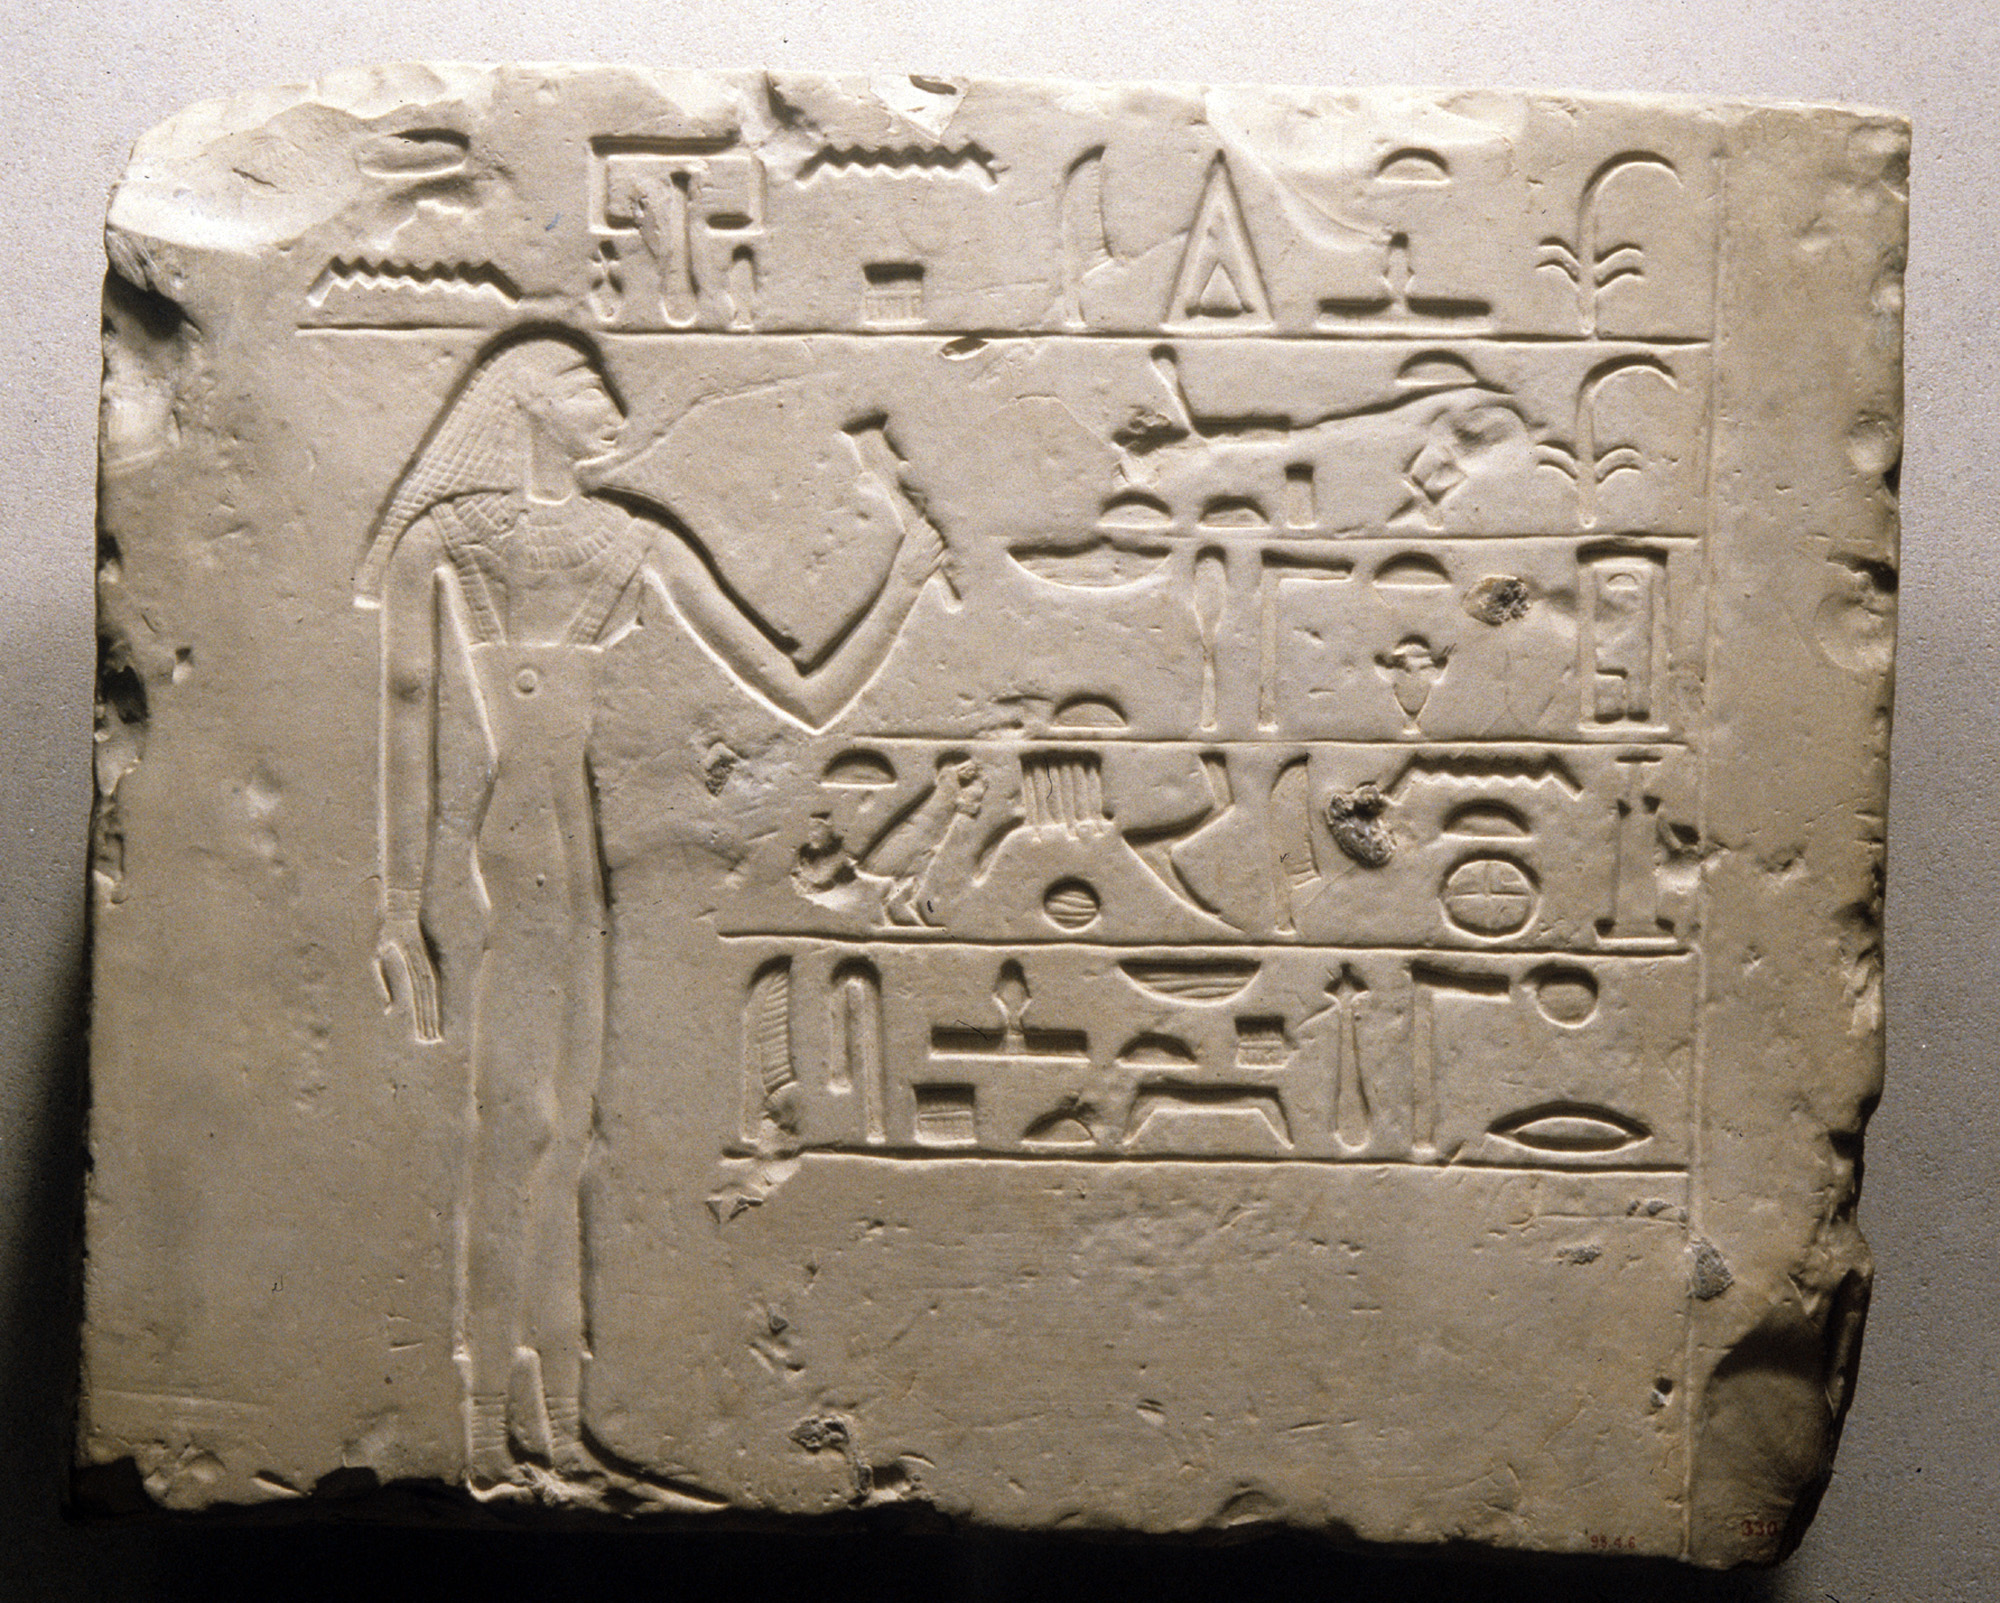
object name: stela, hetepi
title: Tomb Stela of Hetepsi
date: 2323-2100 BCE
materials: limestone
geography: egypt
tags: women,hieroglyphs